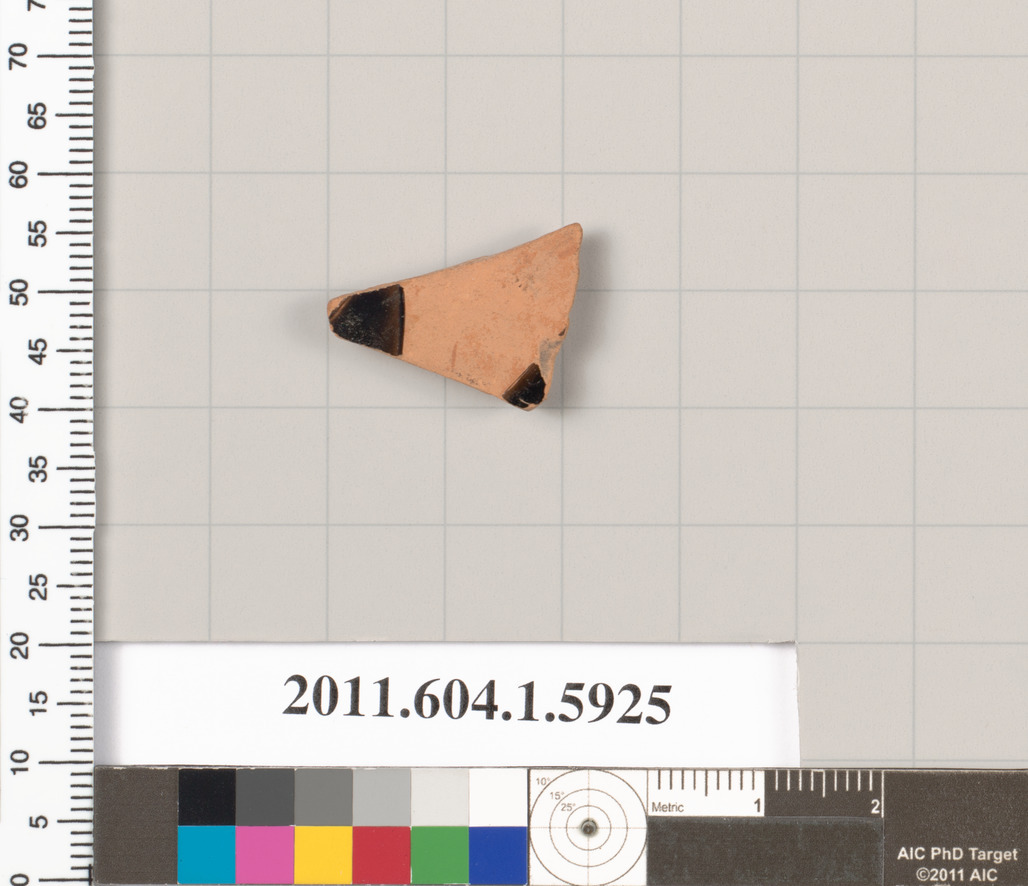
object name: kylix fragment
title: Terracotta fragment of a kylix (drinking cup)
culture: greek, attic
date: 520-510 BCE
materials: terracotta